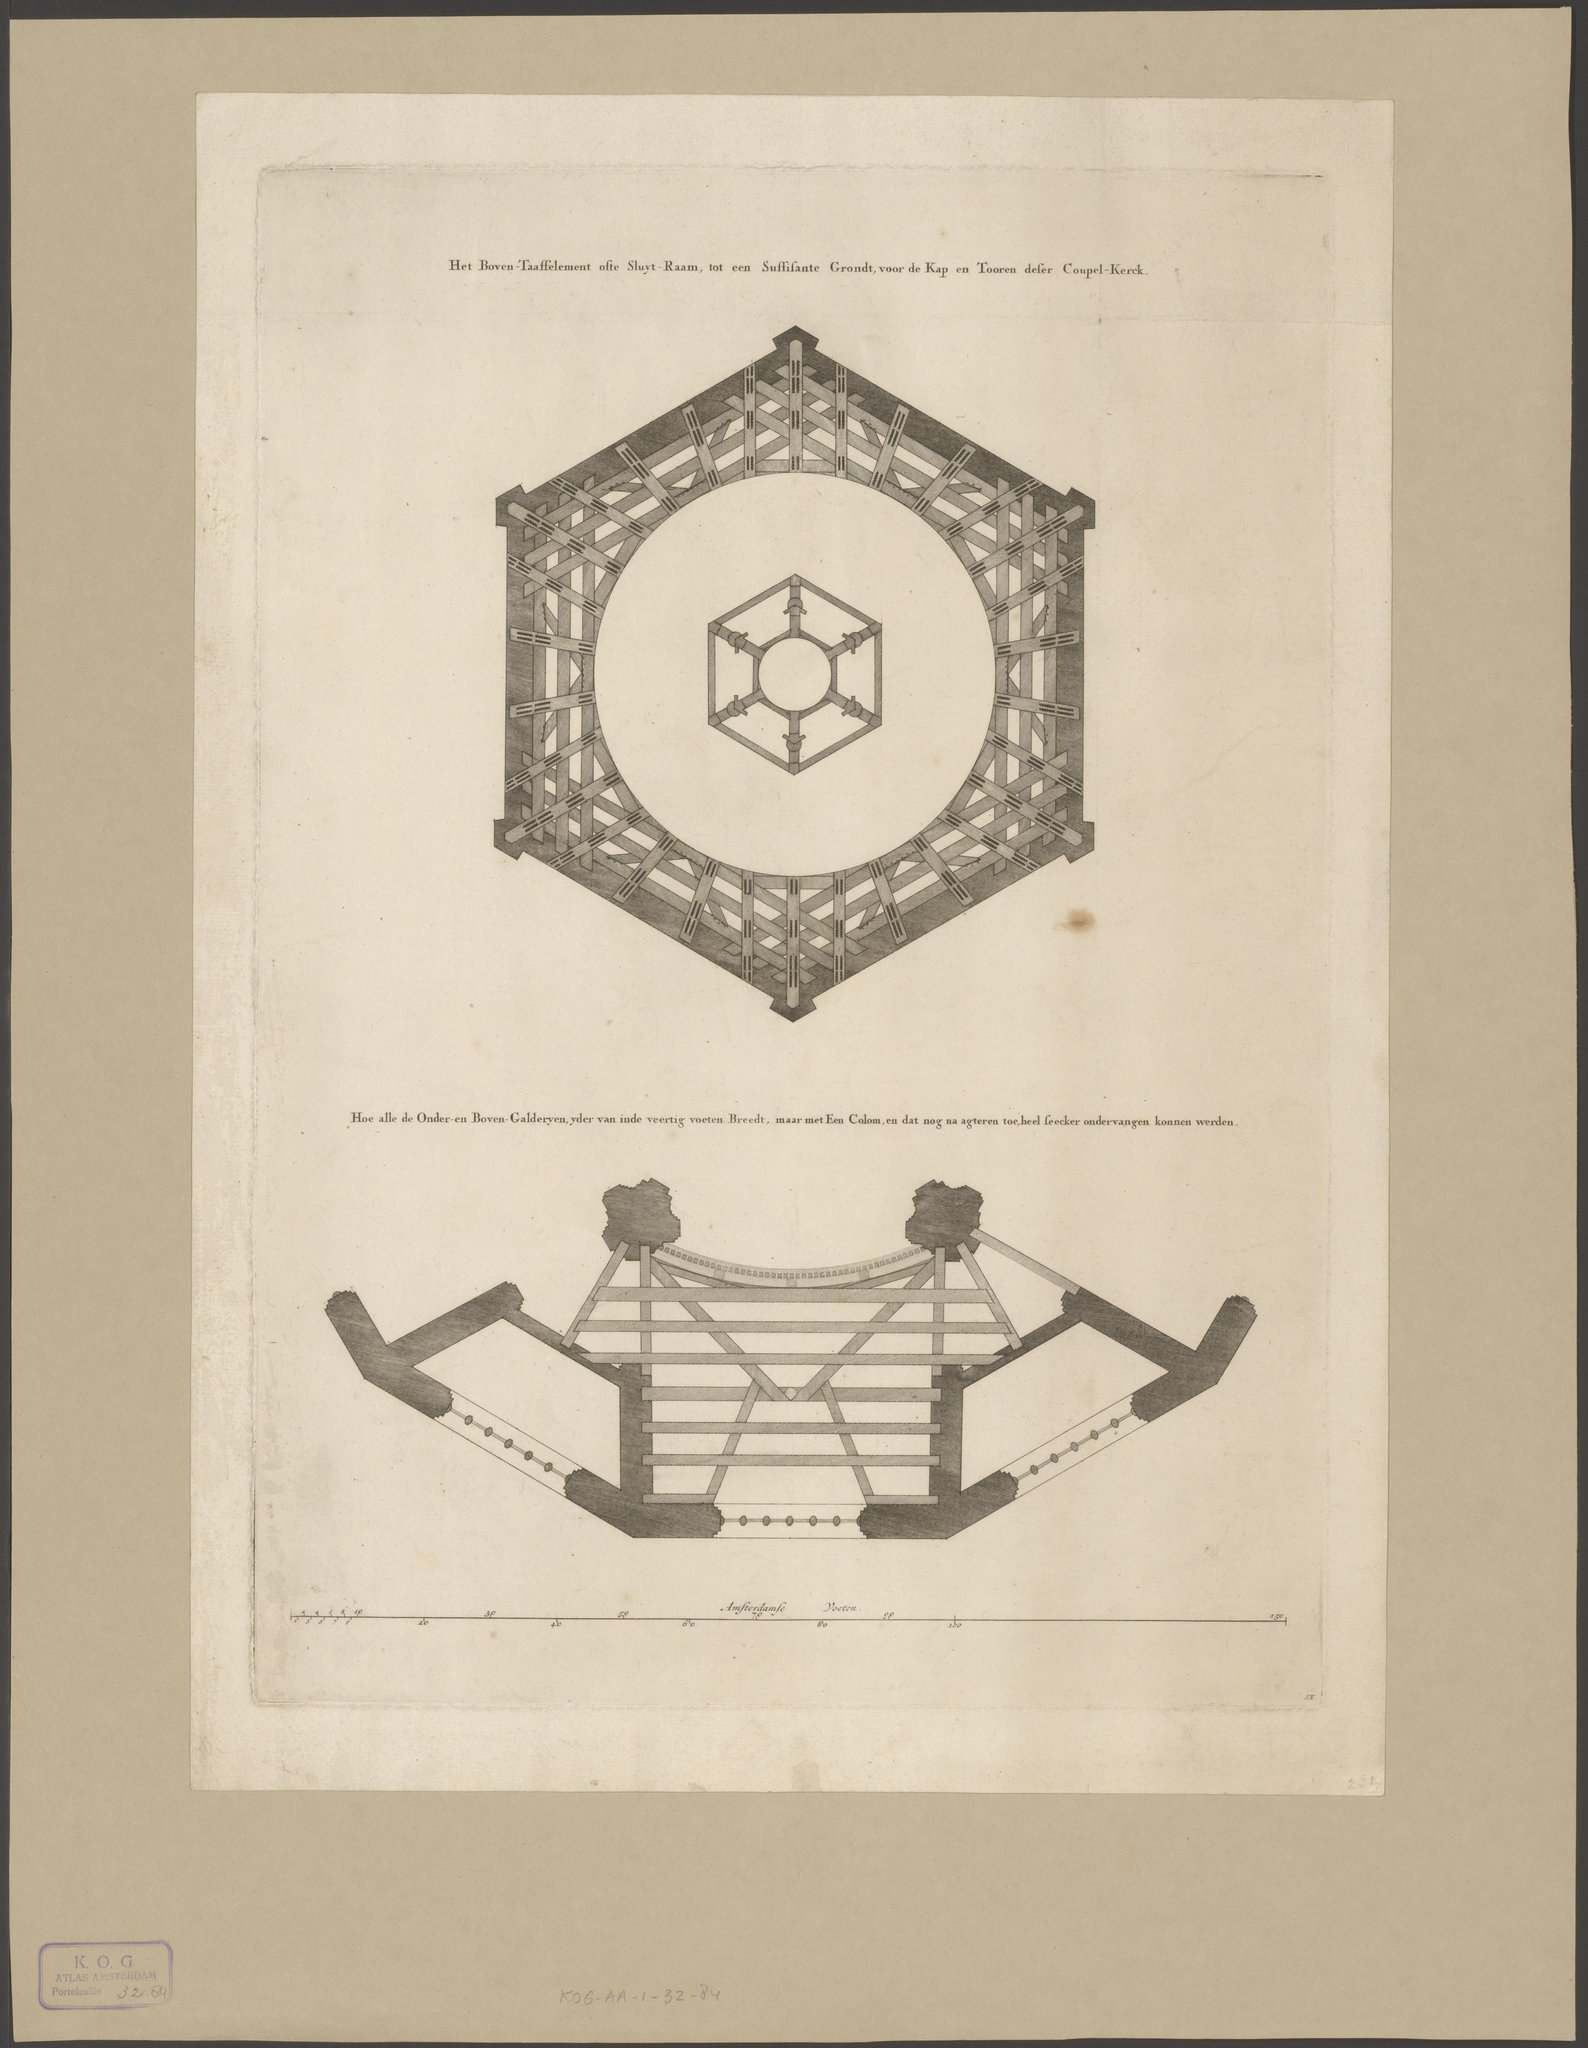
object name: print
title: Nieuw ontwerp voor een koepelkerk op de Botermarkt te Amsterdam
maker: daniël stopendaal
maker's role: print maker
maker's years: 1672-1726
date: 1700-1705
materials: paper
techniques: engraving, etching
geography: amsterdam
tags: interior of church, plan ~ architecture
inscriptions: collector's mark: Lugt 1641b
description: Prent maakt mogelijk onderdeel uit van de serie: Nievv desseyn tot een Seer Groote, Stercke, en om te hooren, heel bequame Coupel-Kerck (…). Deze serie van zeventien prenten werd rond 1700 in opdracht van en naar ontwerp van notaris Nicolaas Listingh gemaakt, mogelijk door Daniël Stoopendaal. Zie daarover: Long, Isaac le. Historische beschryvinge van de reformatie der stadt Amsterdam (…). Amsterdam: Johannes van Septeren (I), 1729, p. 572.